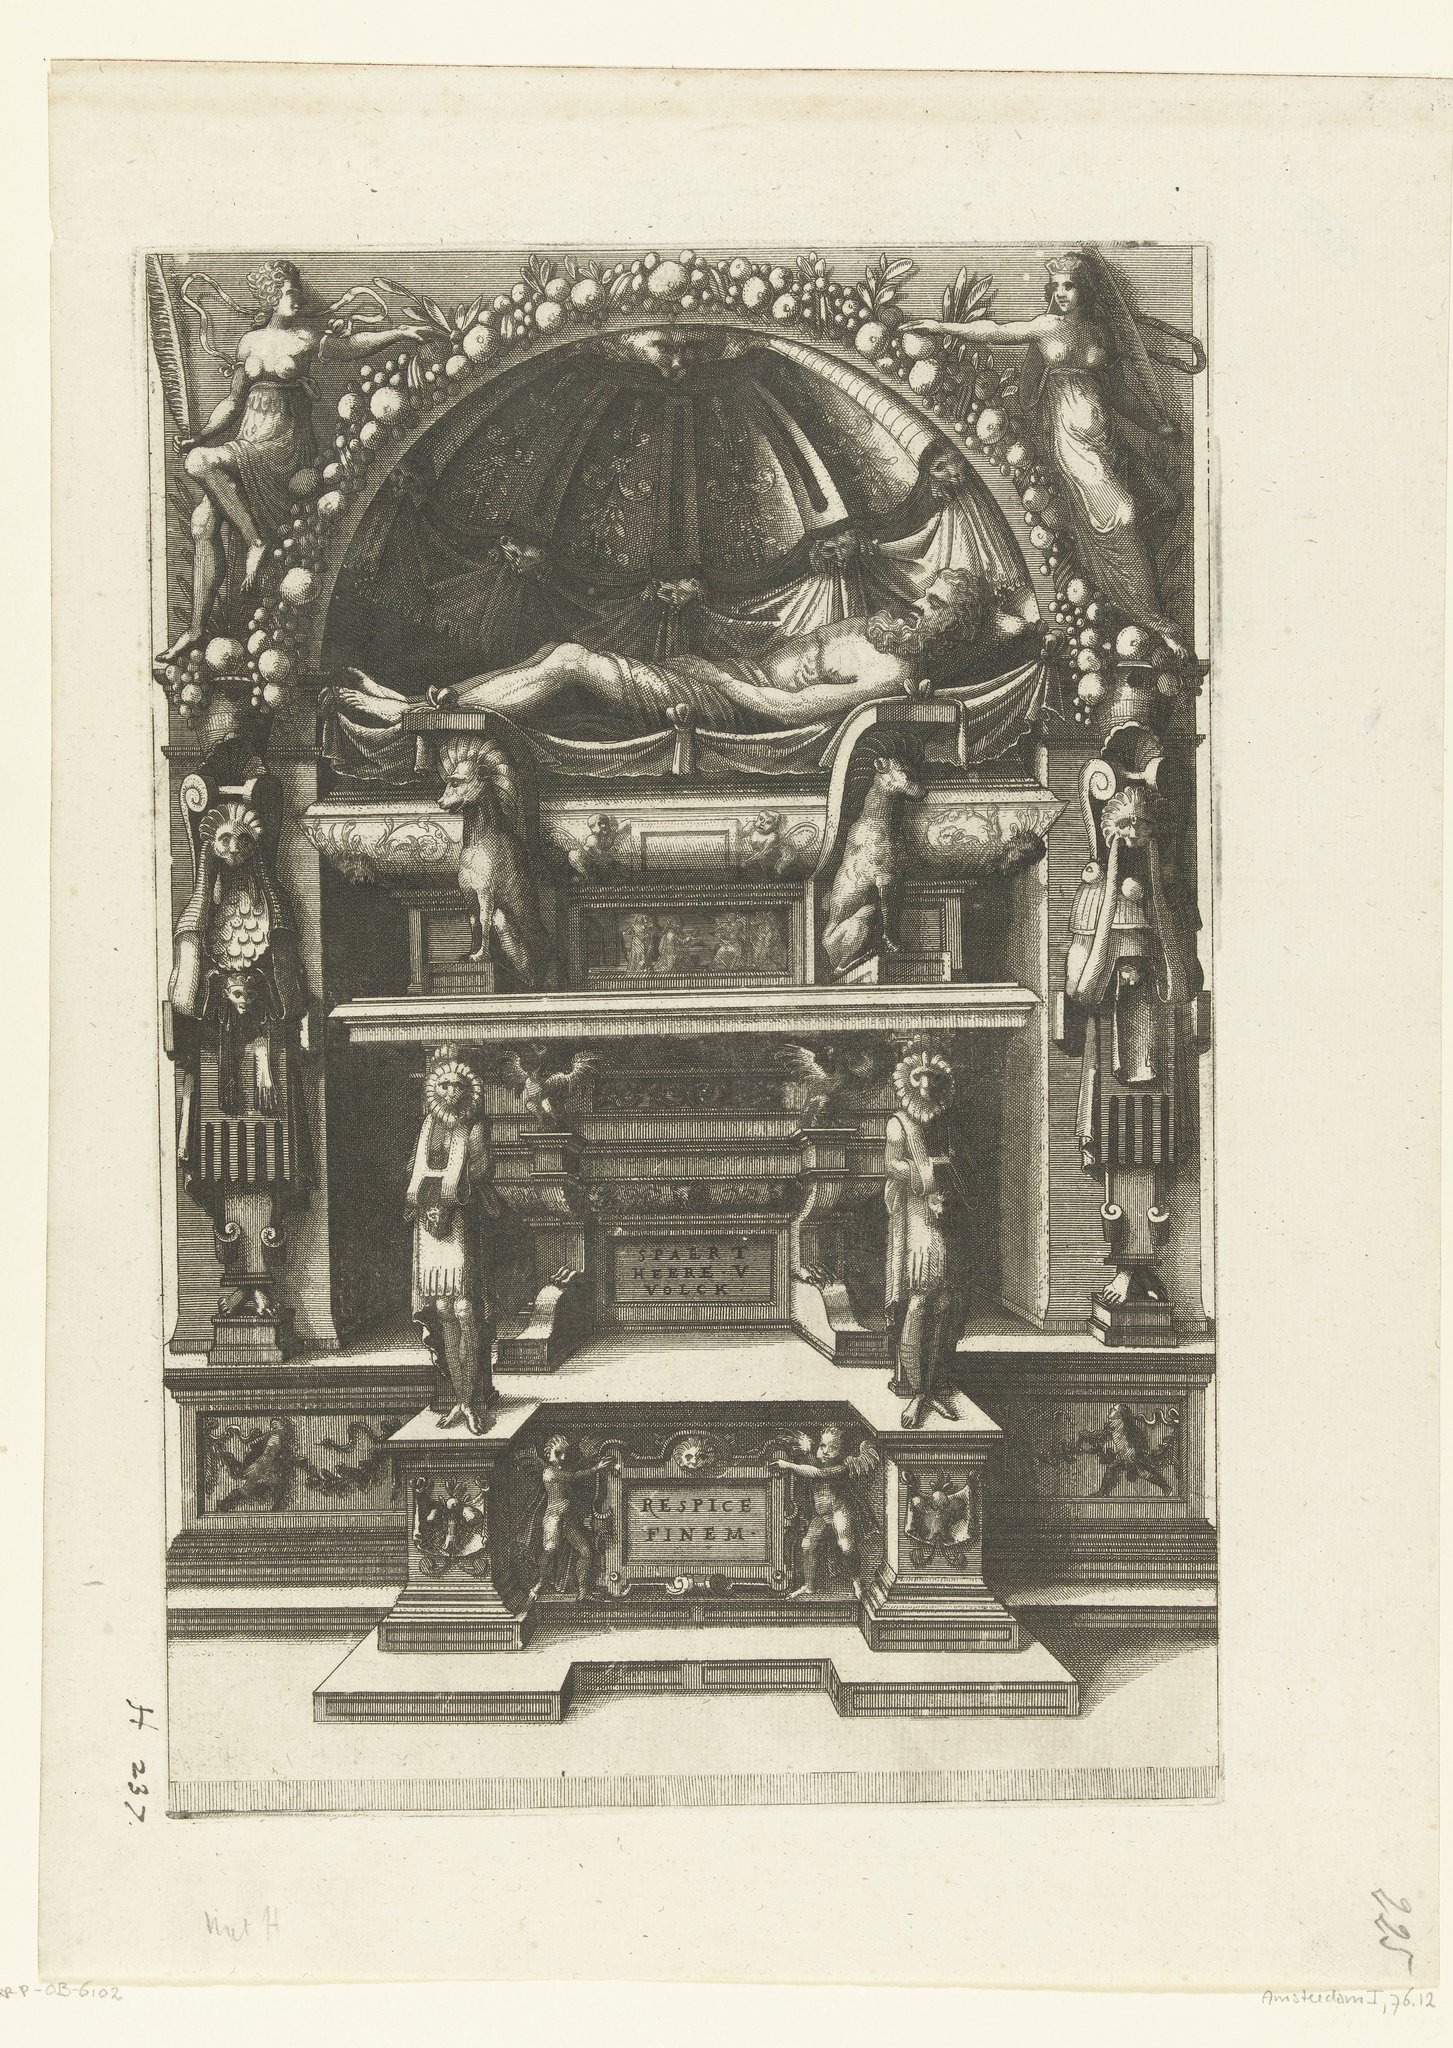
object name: print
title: SPAERT/HEERE.V/VOLCK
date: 1557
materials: paper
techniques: etching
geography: netherlands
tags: ornaments ~ art, grave, tomb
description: In een grote nis op een sokkel staat een sarcofaag waarop een man ligt opgebaard. De nis wordt omlijst door een guirlande van vruchten, opgehouden door twee vrouwen met palmtak in de hand. Aan weerszijden eindigt de guirlande in een vaas die rust op een herme met een leeuwekop. Hoort bij serie bestaande uit een titelblad, een tekstblad en 14 bladen met grotesken met rolwerk, saters, guirlandes, trofeeën, dieren en fantasiewezens.